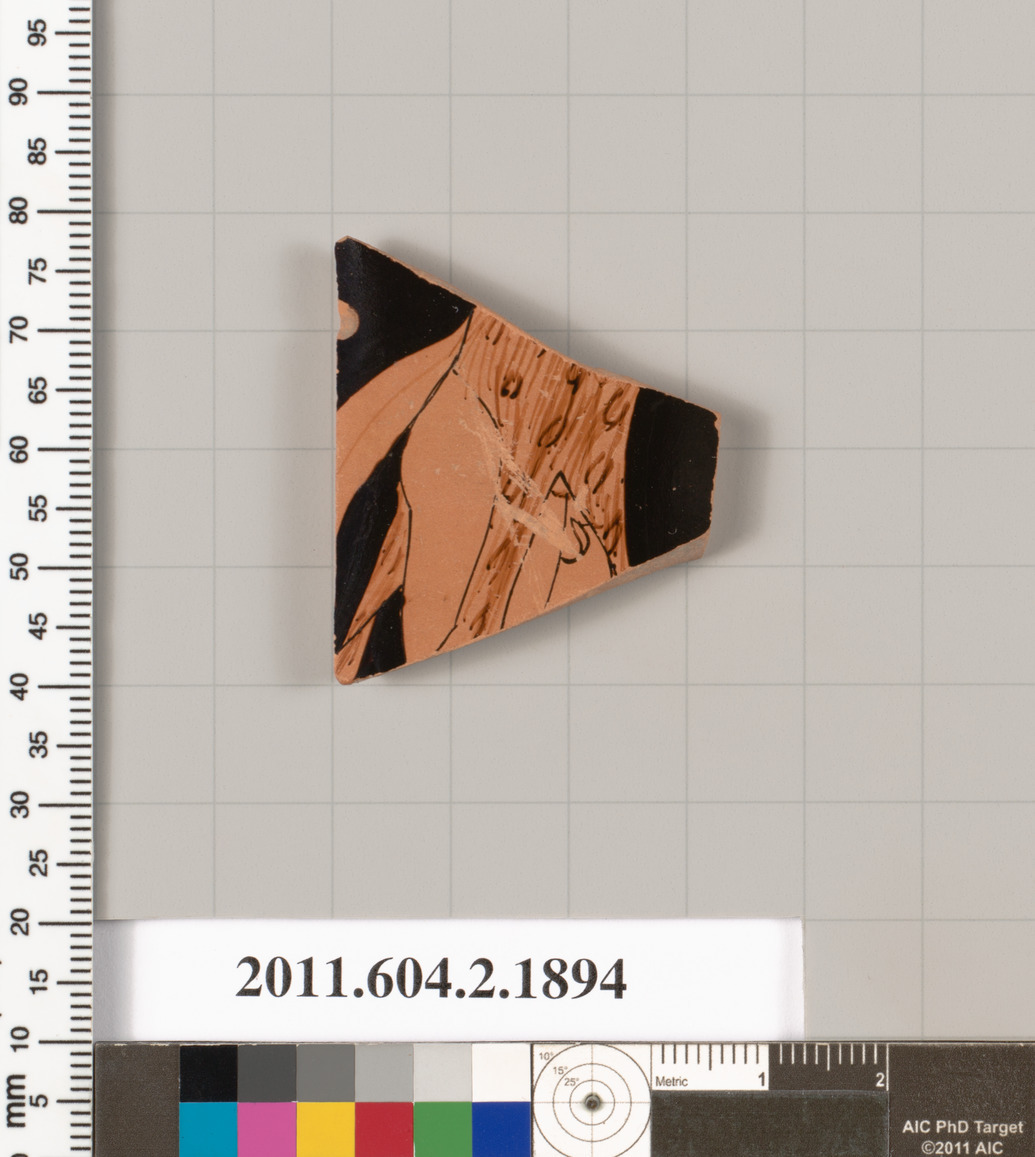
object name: skyphos fragment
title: Terracotta fragment of a skyphos (deep drinking cup)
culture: greek, attic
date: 430-400 BCE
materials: terracotta